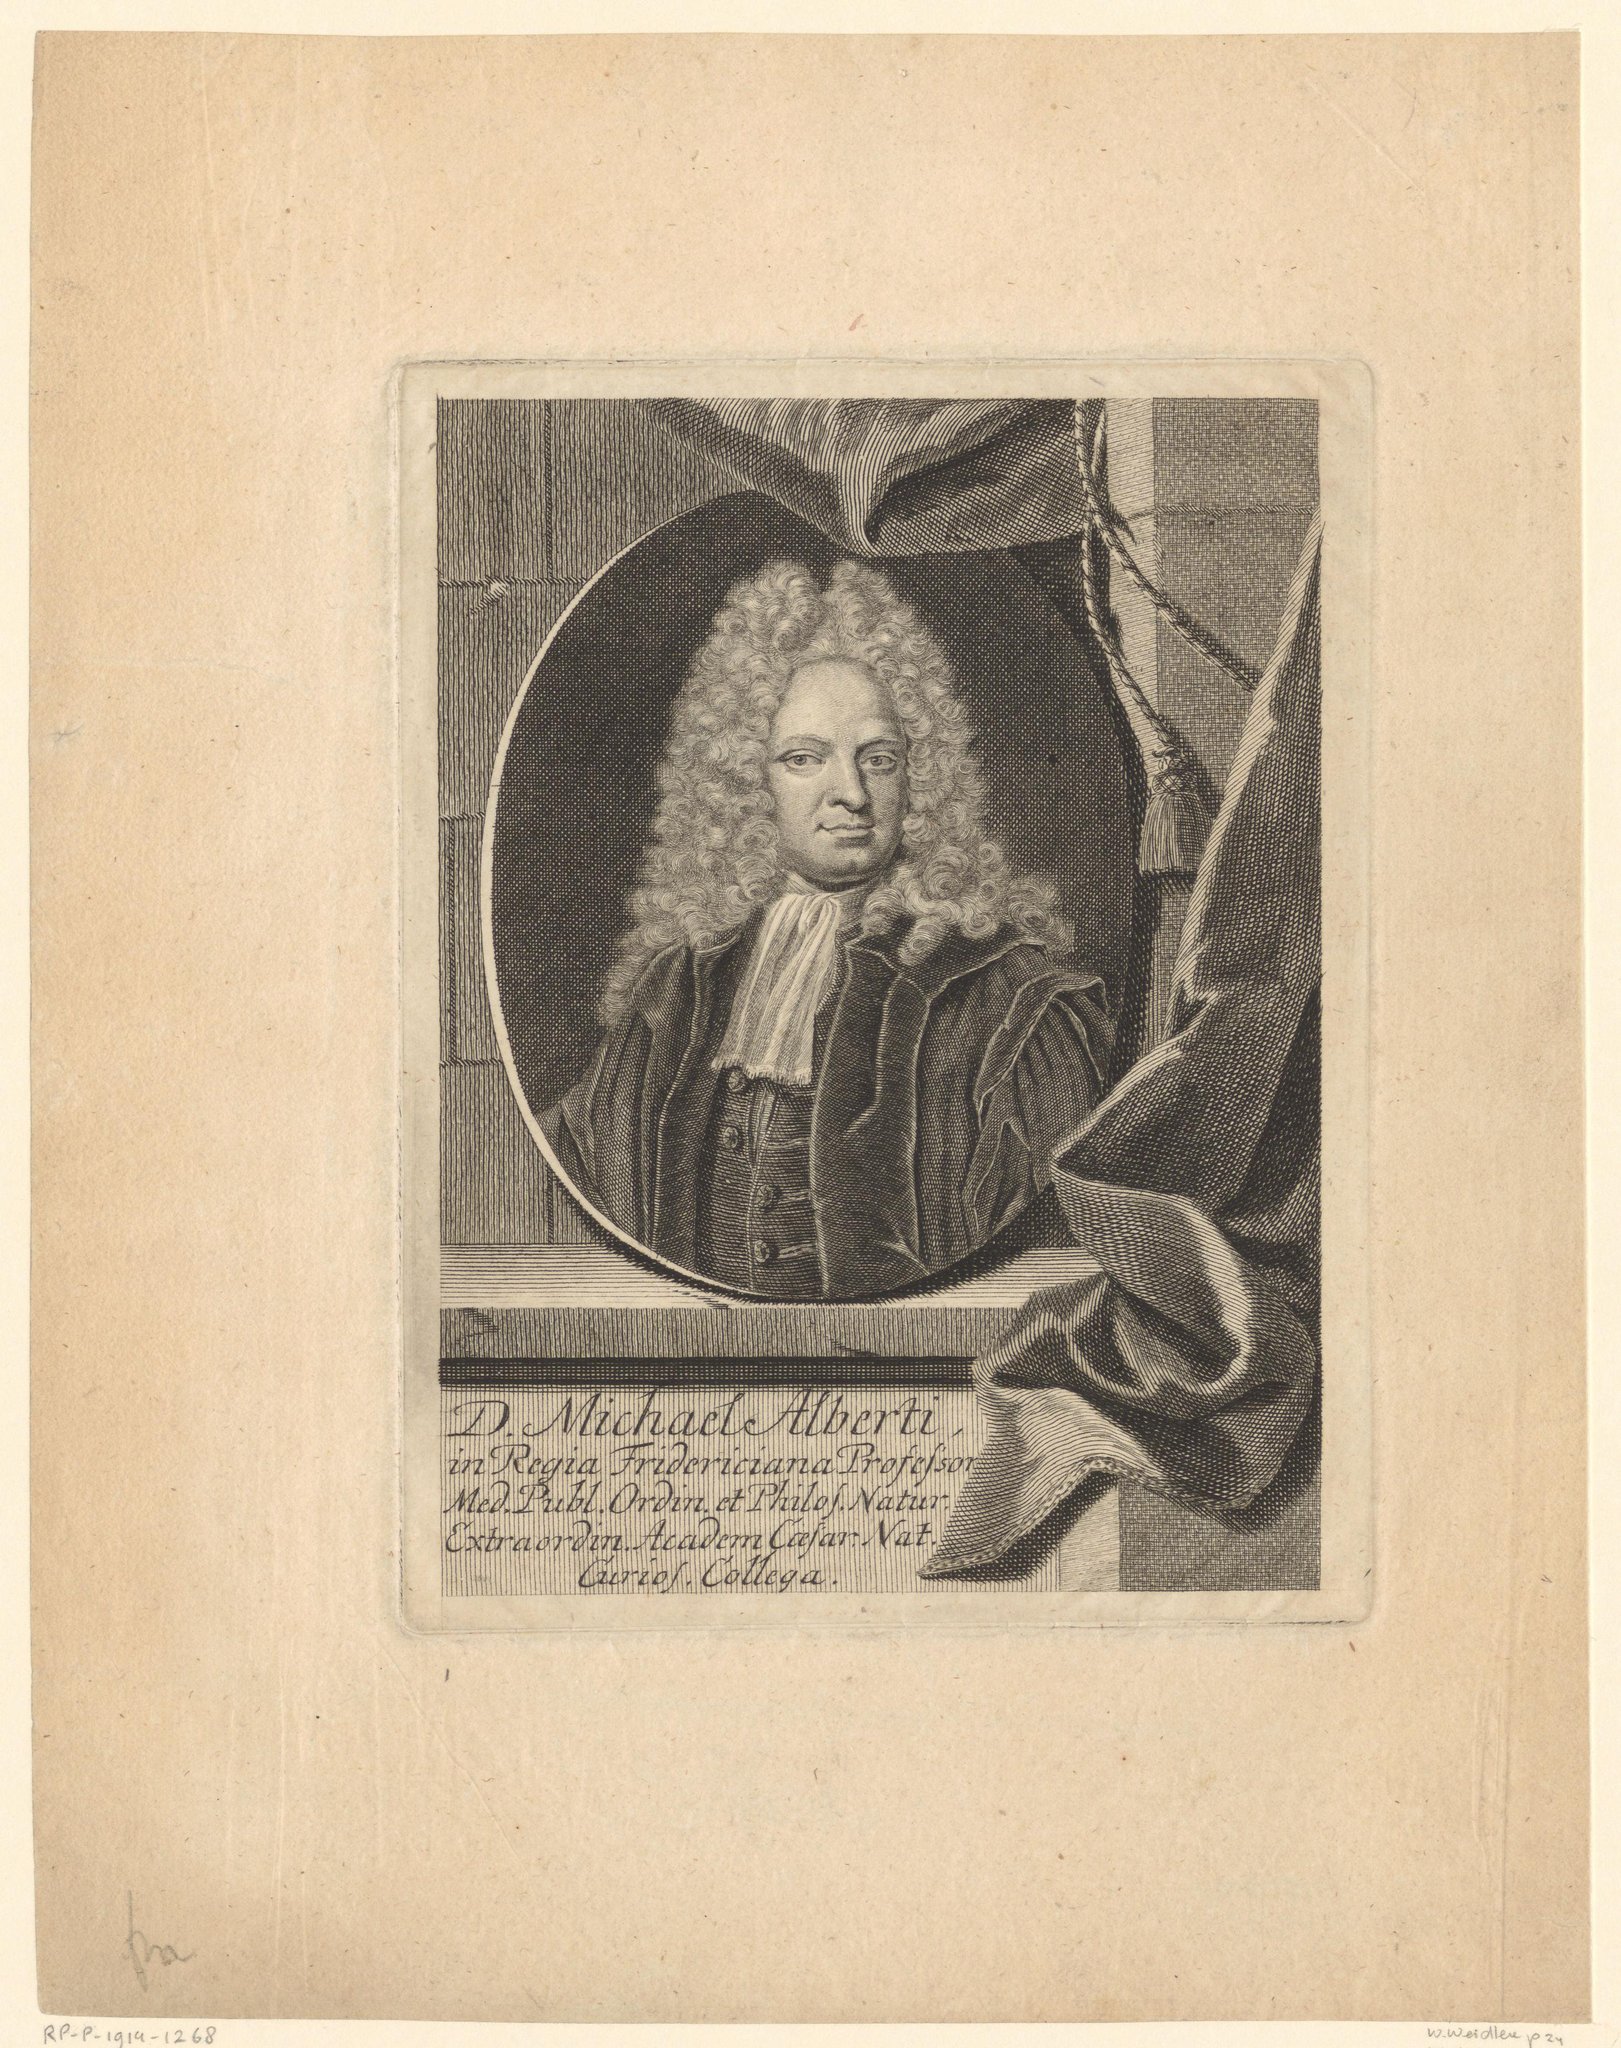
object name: print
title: Portret van Michael Alberti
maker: martin bernigeroth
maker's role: print maker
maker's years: 1670-1733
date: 1713-1733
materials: paper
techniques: engraving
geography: leipzig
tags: michael alberti, historical persons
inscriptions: collector's mark: Lugt 2228